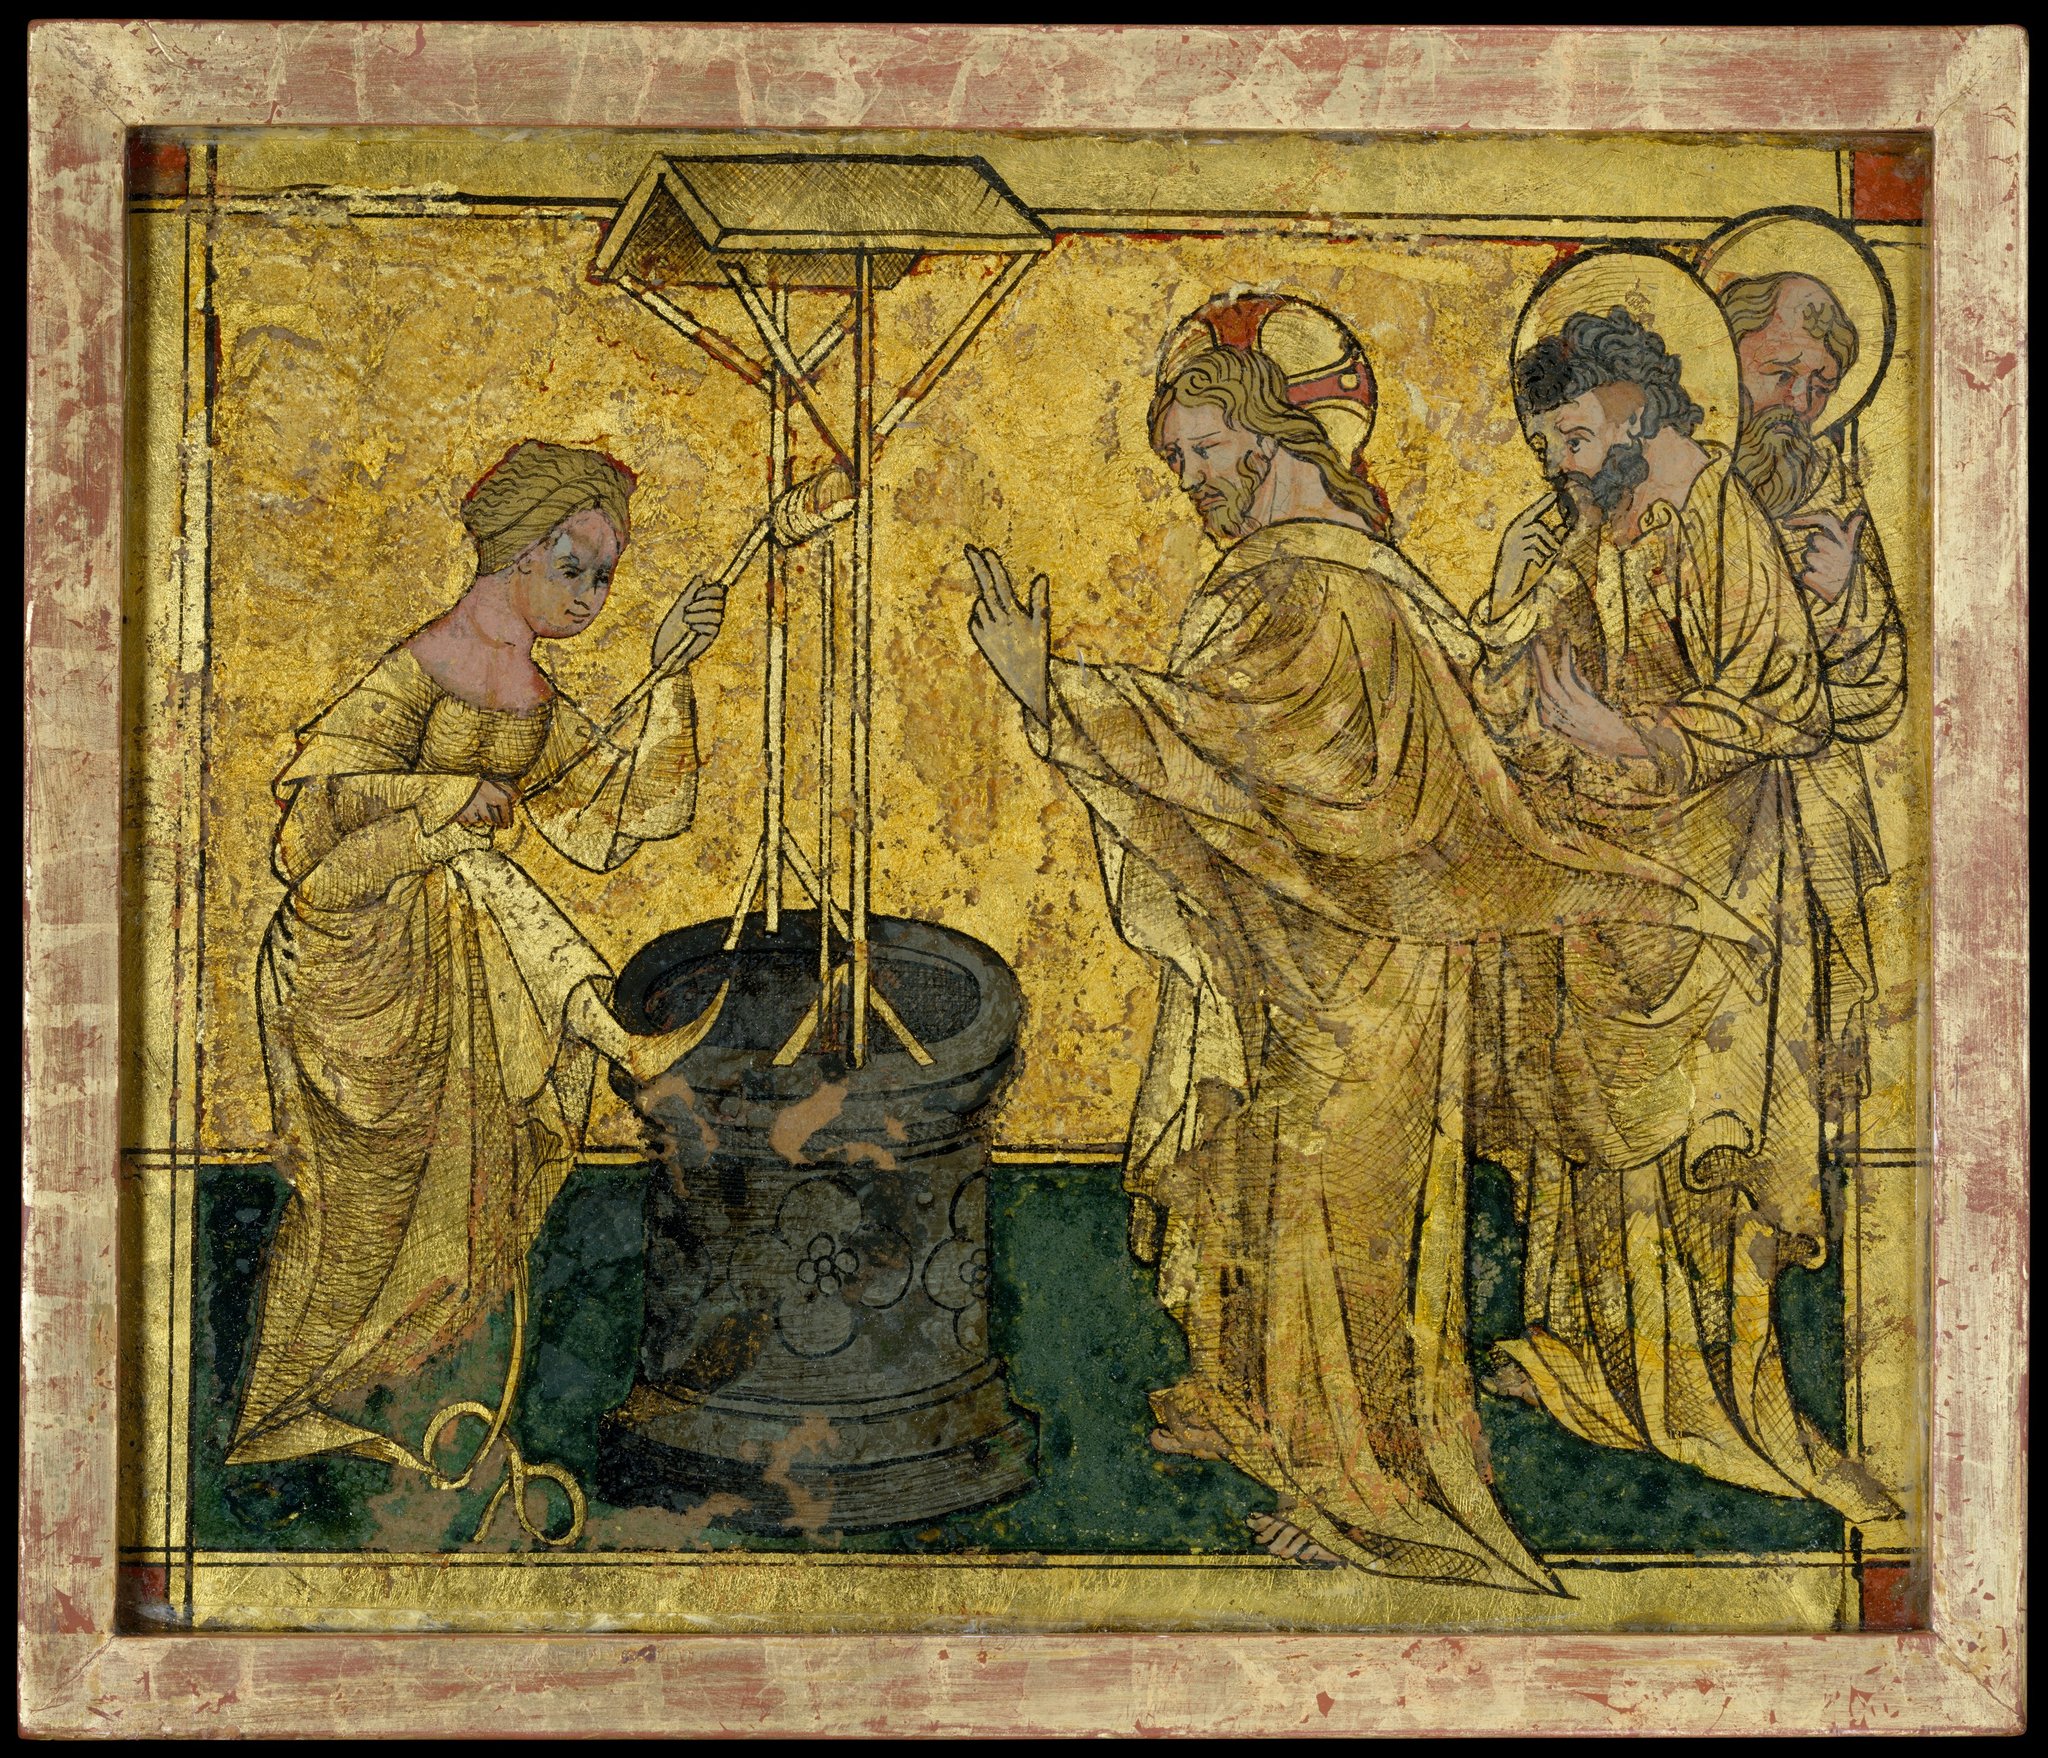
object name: framed panel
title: Jesus and the Samaritan Woman at the Well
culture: german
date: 1420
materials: glass, gold leaf, paint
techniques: etching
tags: wells,women,christ